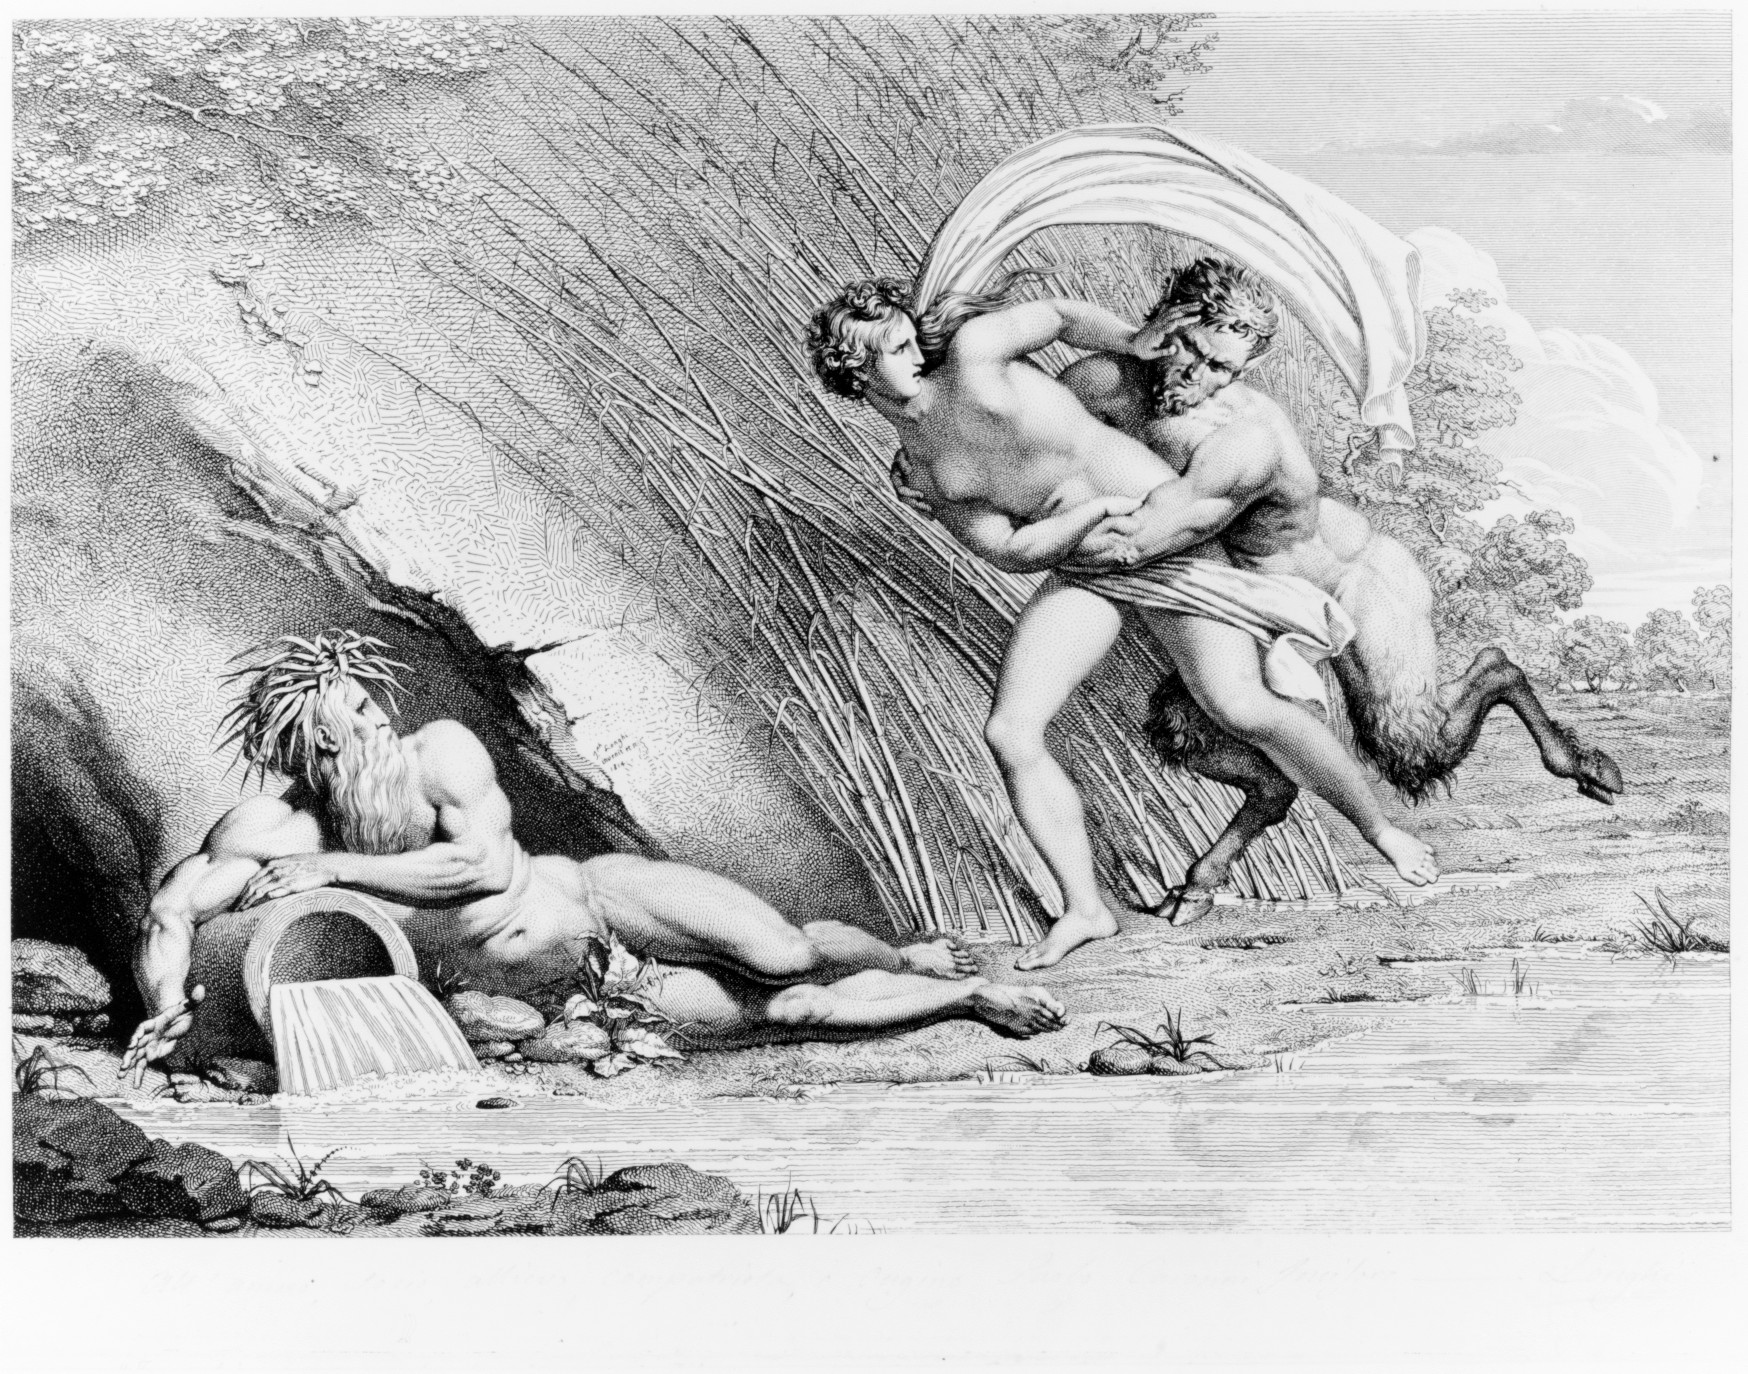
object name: print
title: Pan and Syrinx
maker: giuseppe longhi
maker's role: artist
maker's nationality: italian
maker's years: 1766-1831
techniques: engraving, etching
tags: nymphs